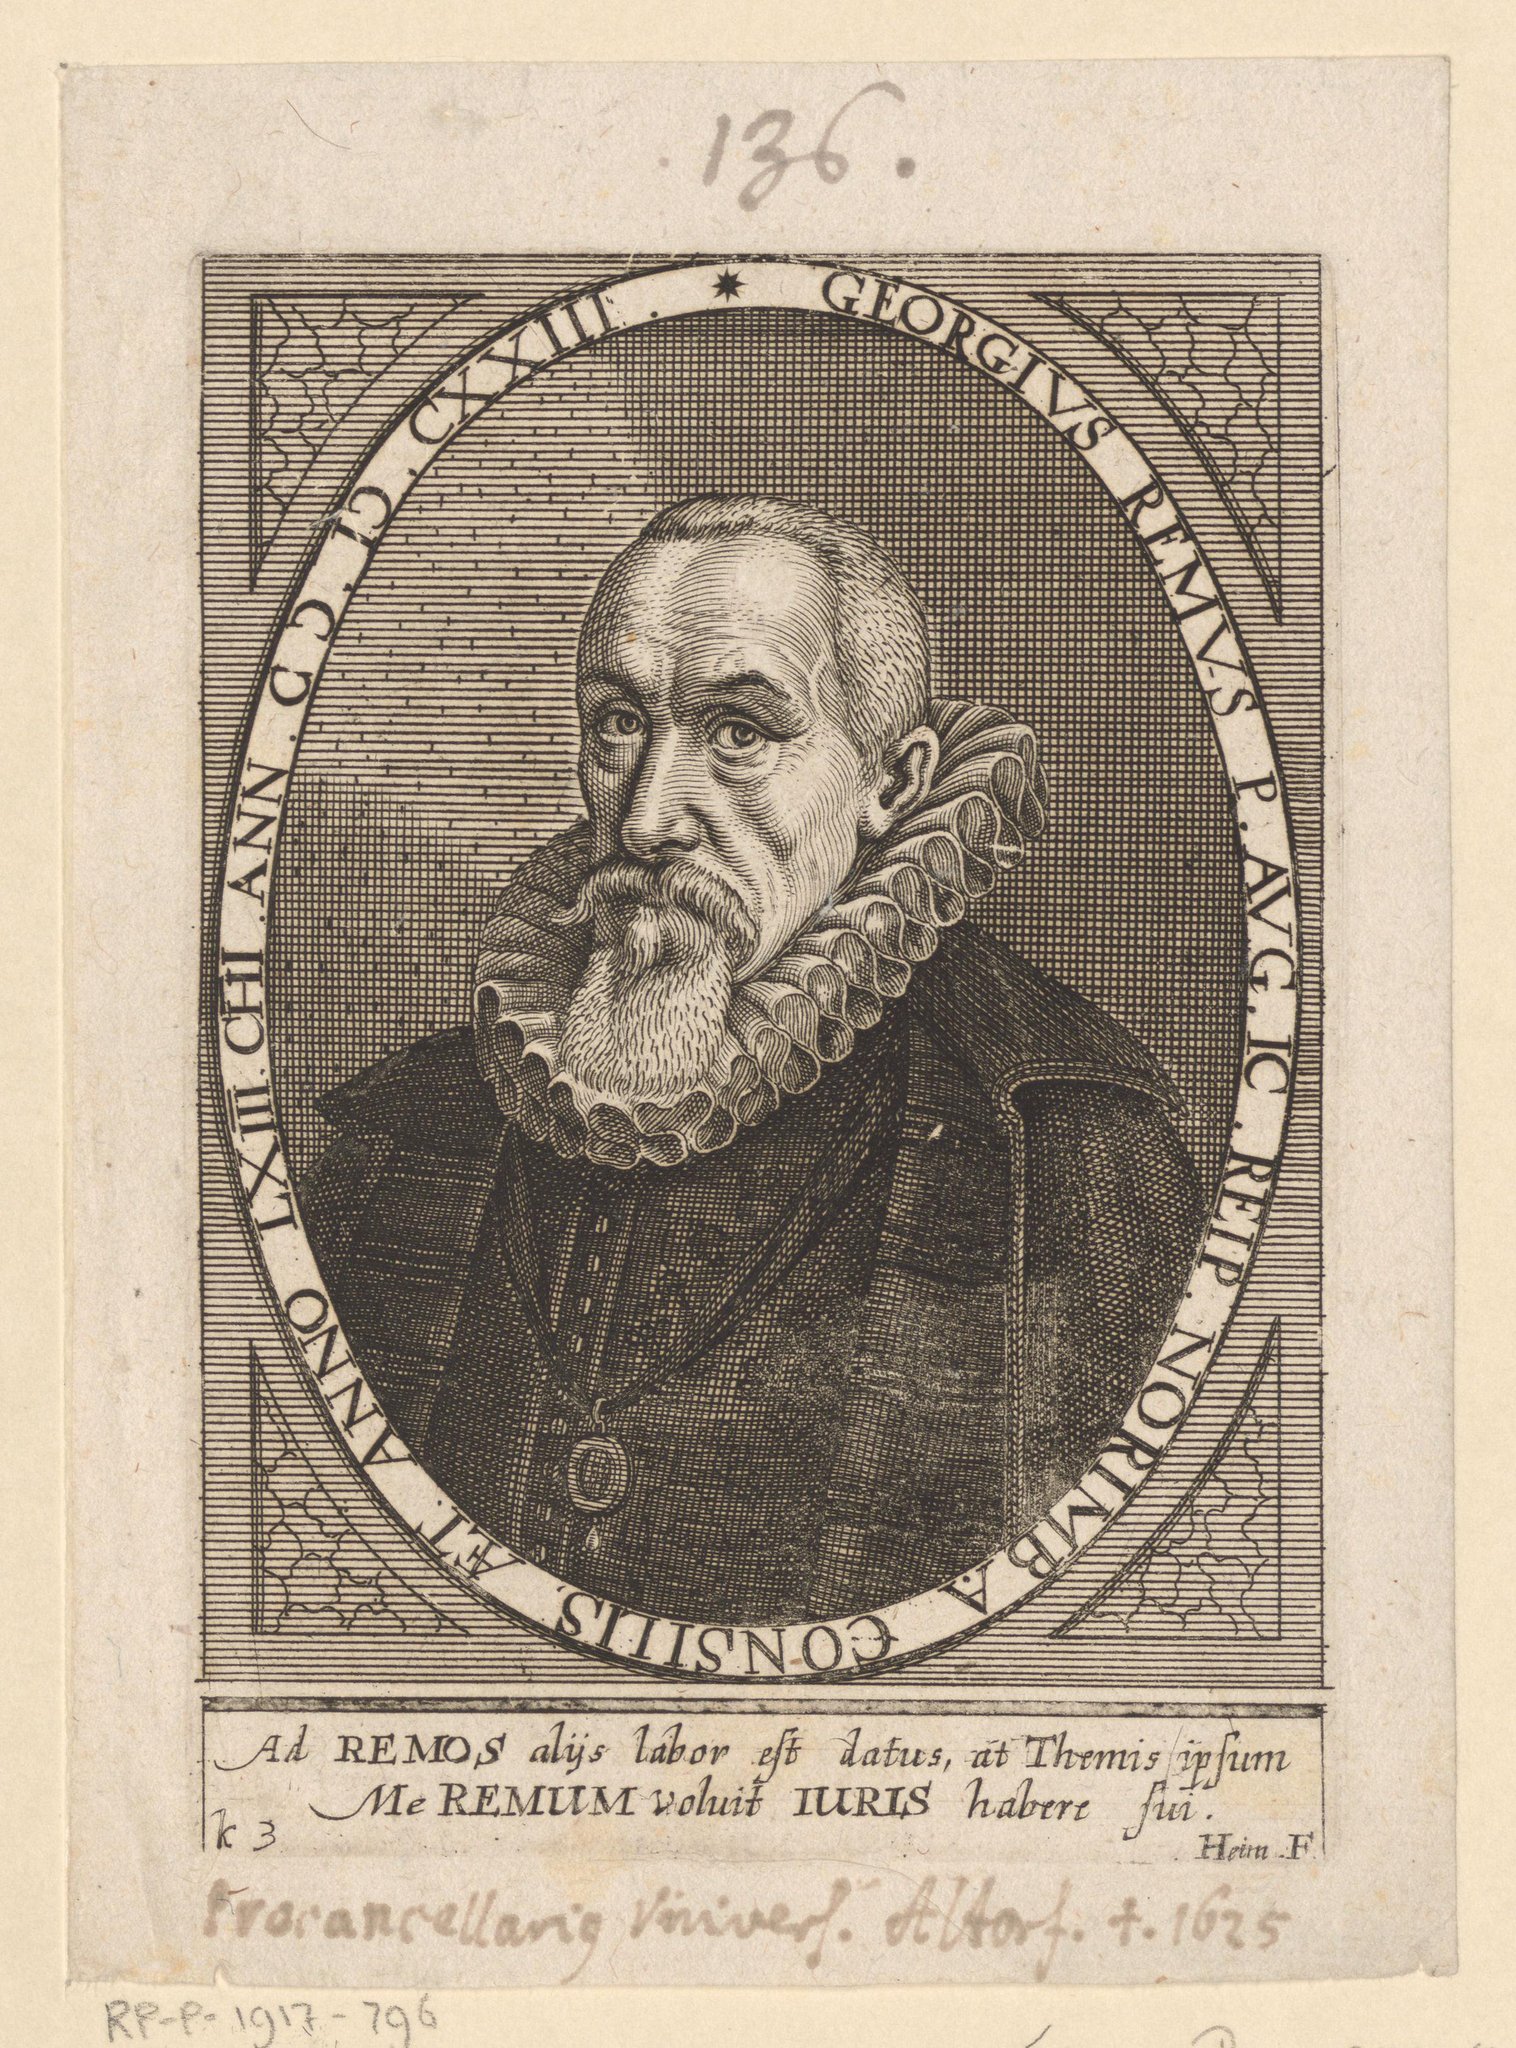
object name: print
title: Portret van Georgius Rem op 63-jarige leeftijd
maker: sebastian furck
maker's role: print maker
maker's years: 1600-1655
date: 1650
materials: paper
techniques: engraving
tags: historical persons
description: Prent mogelijk uit: Boissard, Jean Jacques. Bibliotheca chalcographica (...). Frankfurt am Main: Johannes Ammon, 1650, dl. VI.